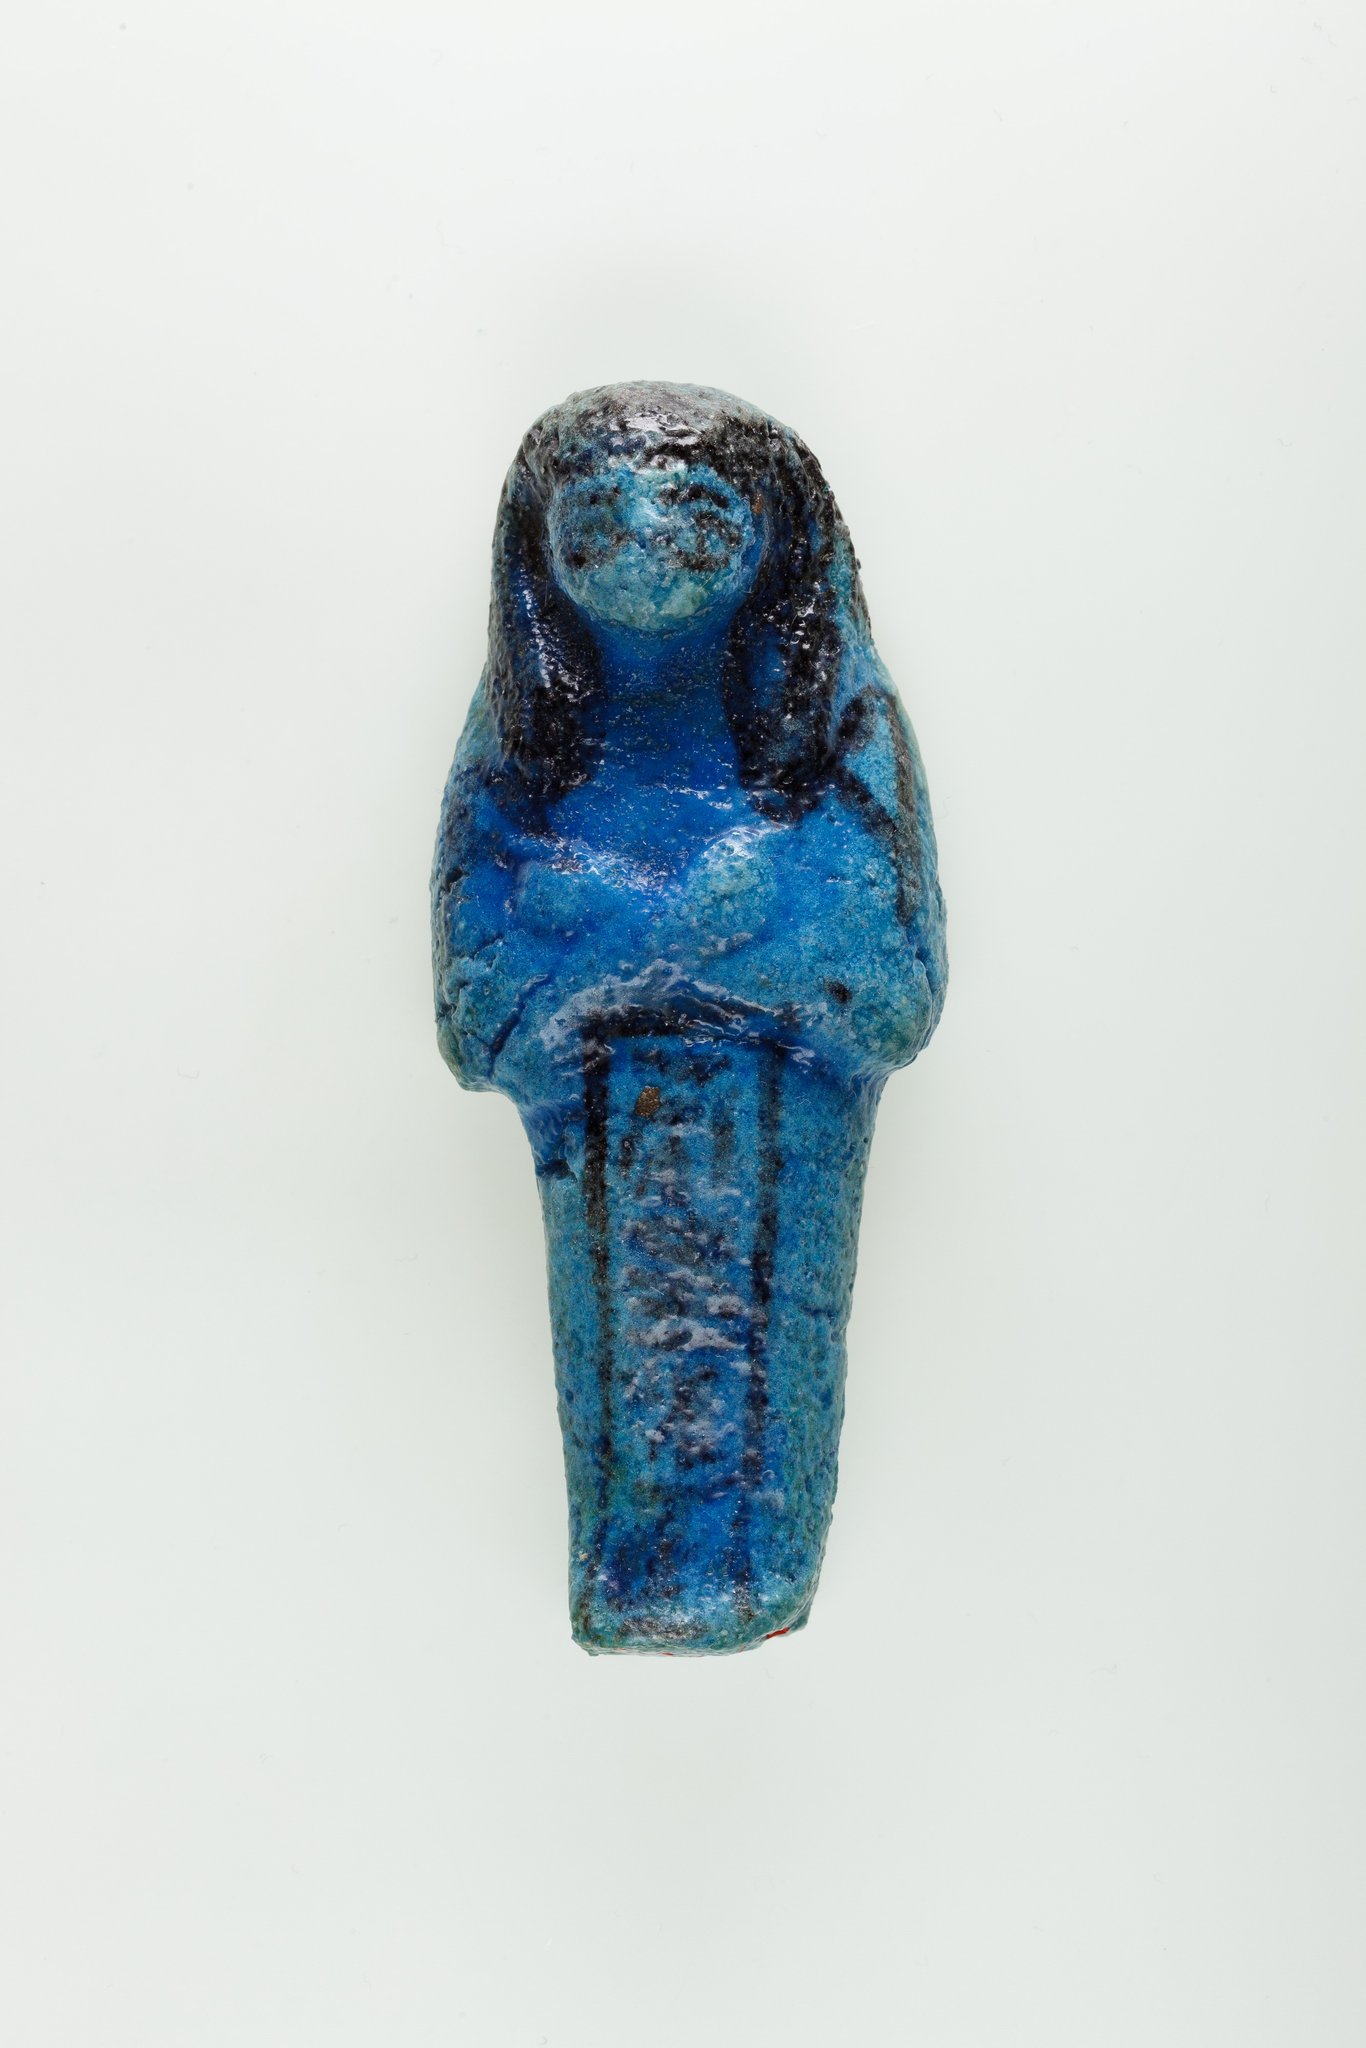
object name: shabti, worker, nauny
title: Worker Shabti of Nauny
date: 1050 BCE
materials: faience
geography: egypt